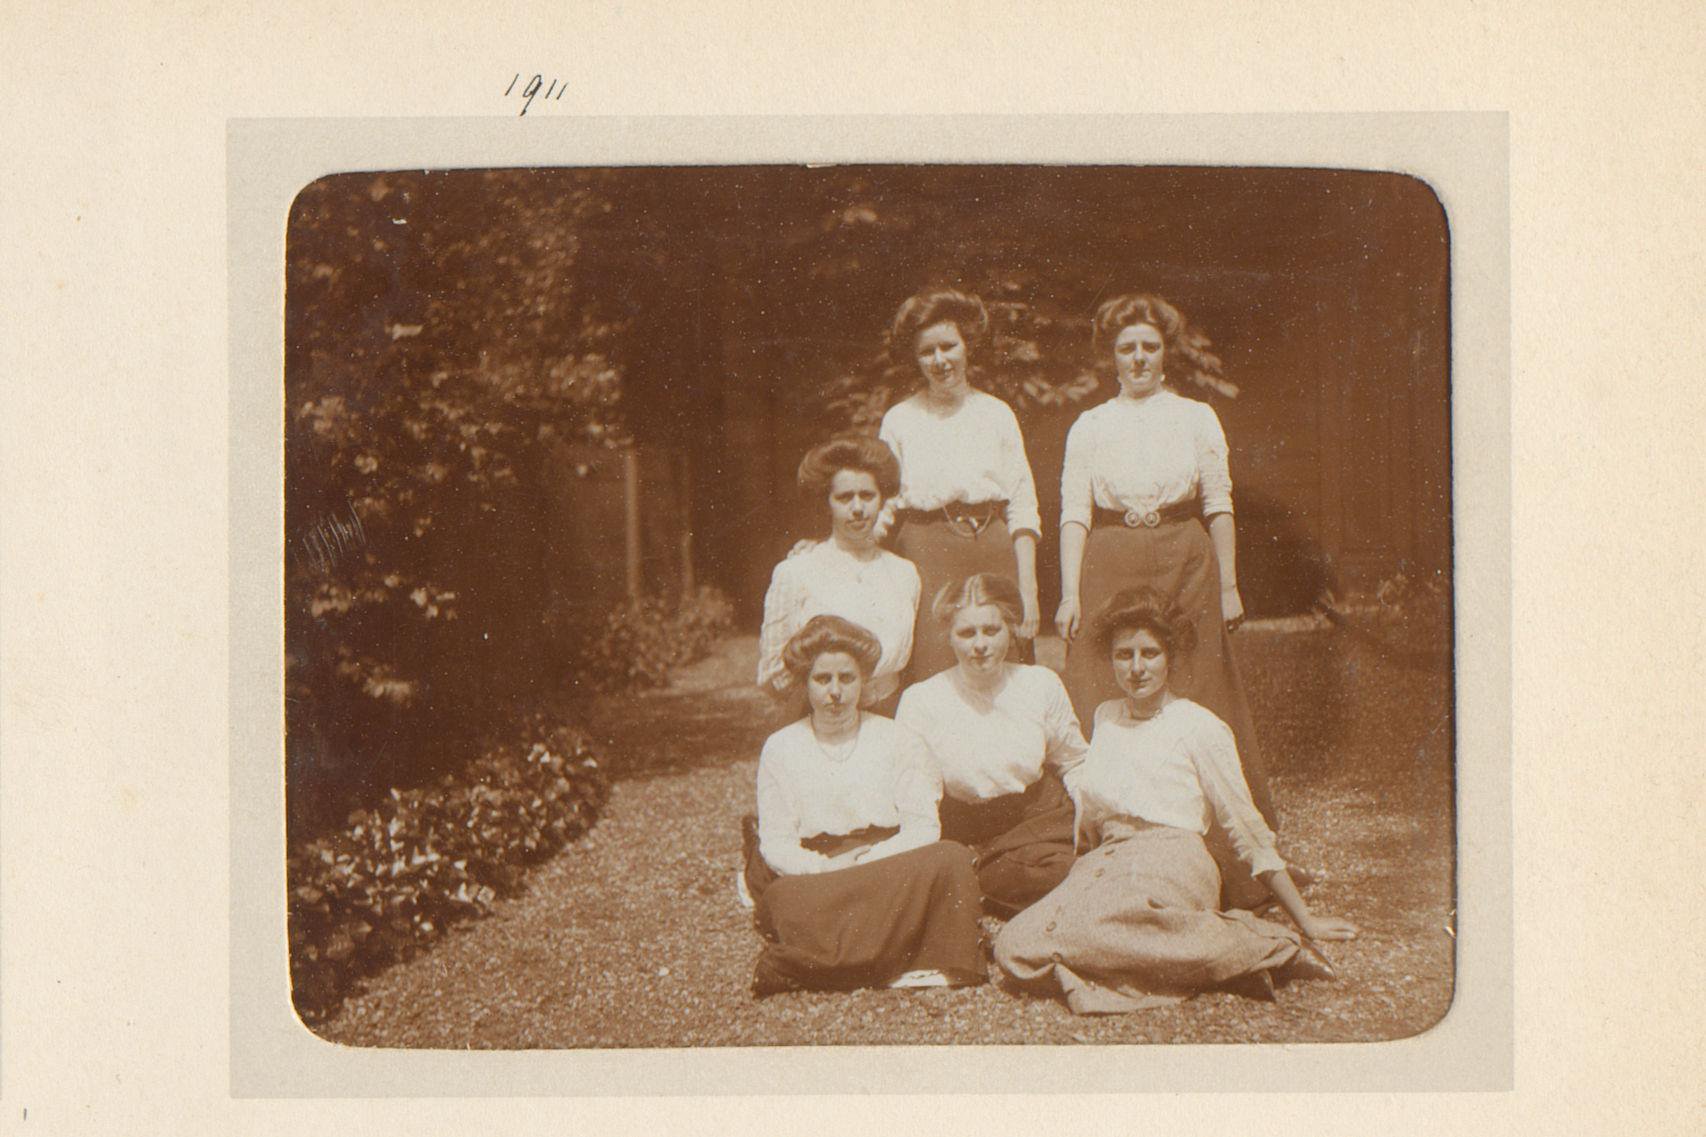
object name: album leaf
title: Groepsportret van zes vrouwen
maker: liesbeth overhoff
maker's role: fotograaf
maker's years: 1895-1969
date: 1911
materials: paper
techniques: gelatin silver print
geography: wijk aan zee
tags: historical persons - bb - woman, adult woman (+ six persons)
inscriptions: inscription: ‘1911’